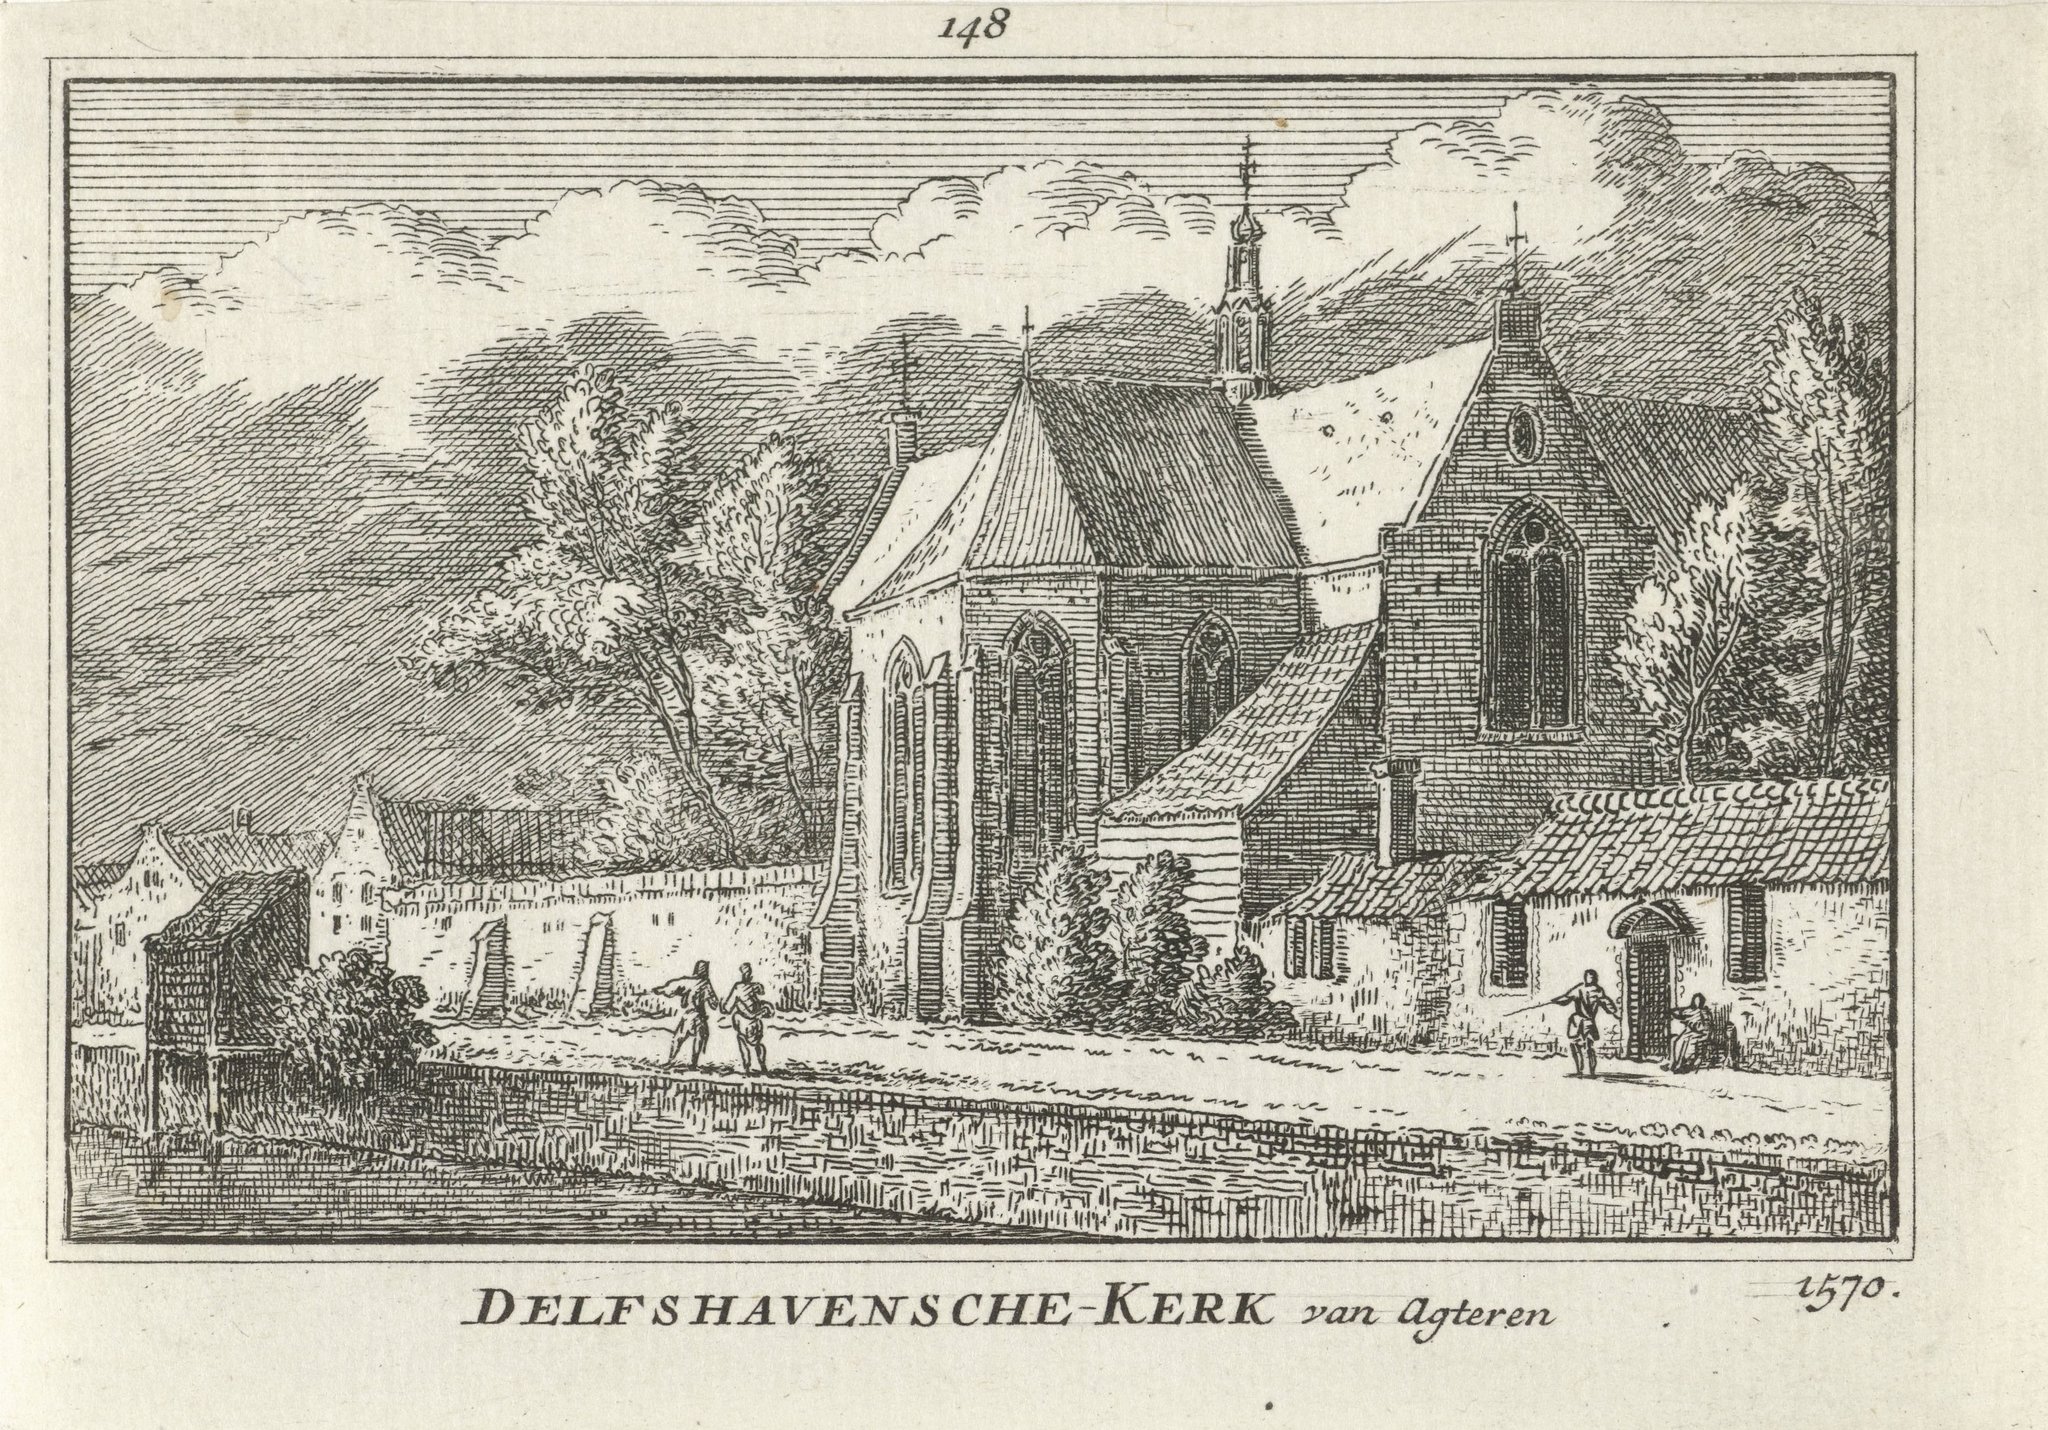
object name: print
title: Gezicht op de achterkant van de Oude of Pelgrimvaderskerk te Delfshaven, 1570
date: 1727-1733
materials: paper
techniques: etching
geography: amsterdam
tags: church (exterior), delfshaven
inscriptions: collector's mark: Lugt 2228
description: Illustratie uit: Abraham Rademaker, Matthaeus Brouërius van Niedek, Isaac Le Long, Kabinet van Nederlandsche en Kleefsche outheden en (...) voorname stads- en landgebouwen, Willem Barents en Antoni Schoonenburg: Amsterdam, 1727-1733, ill. nr. 148.